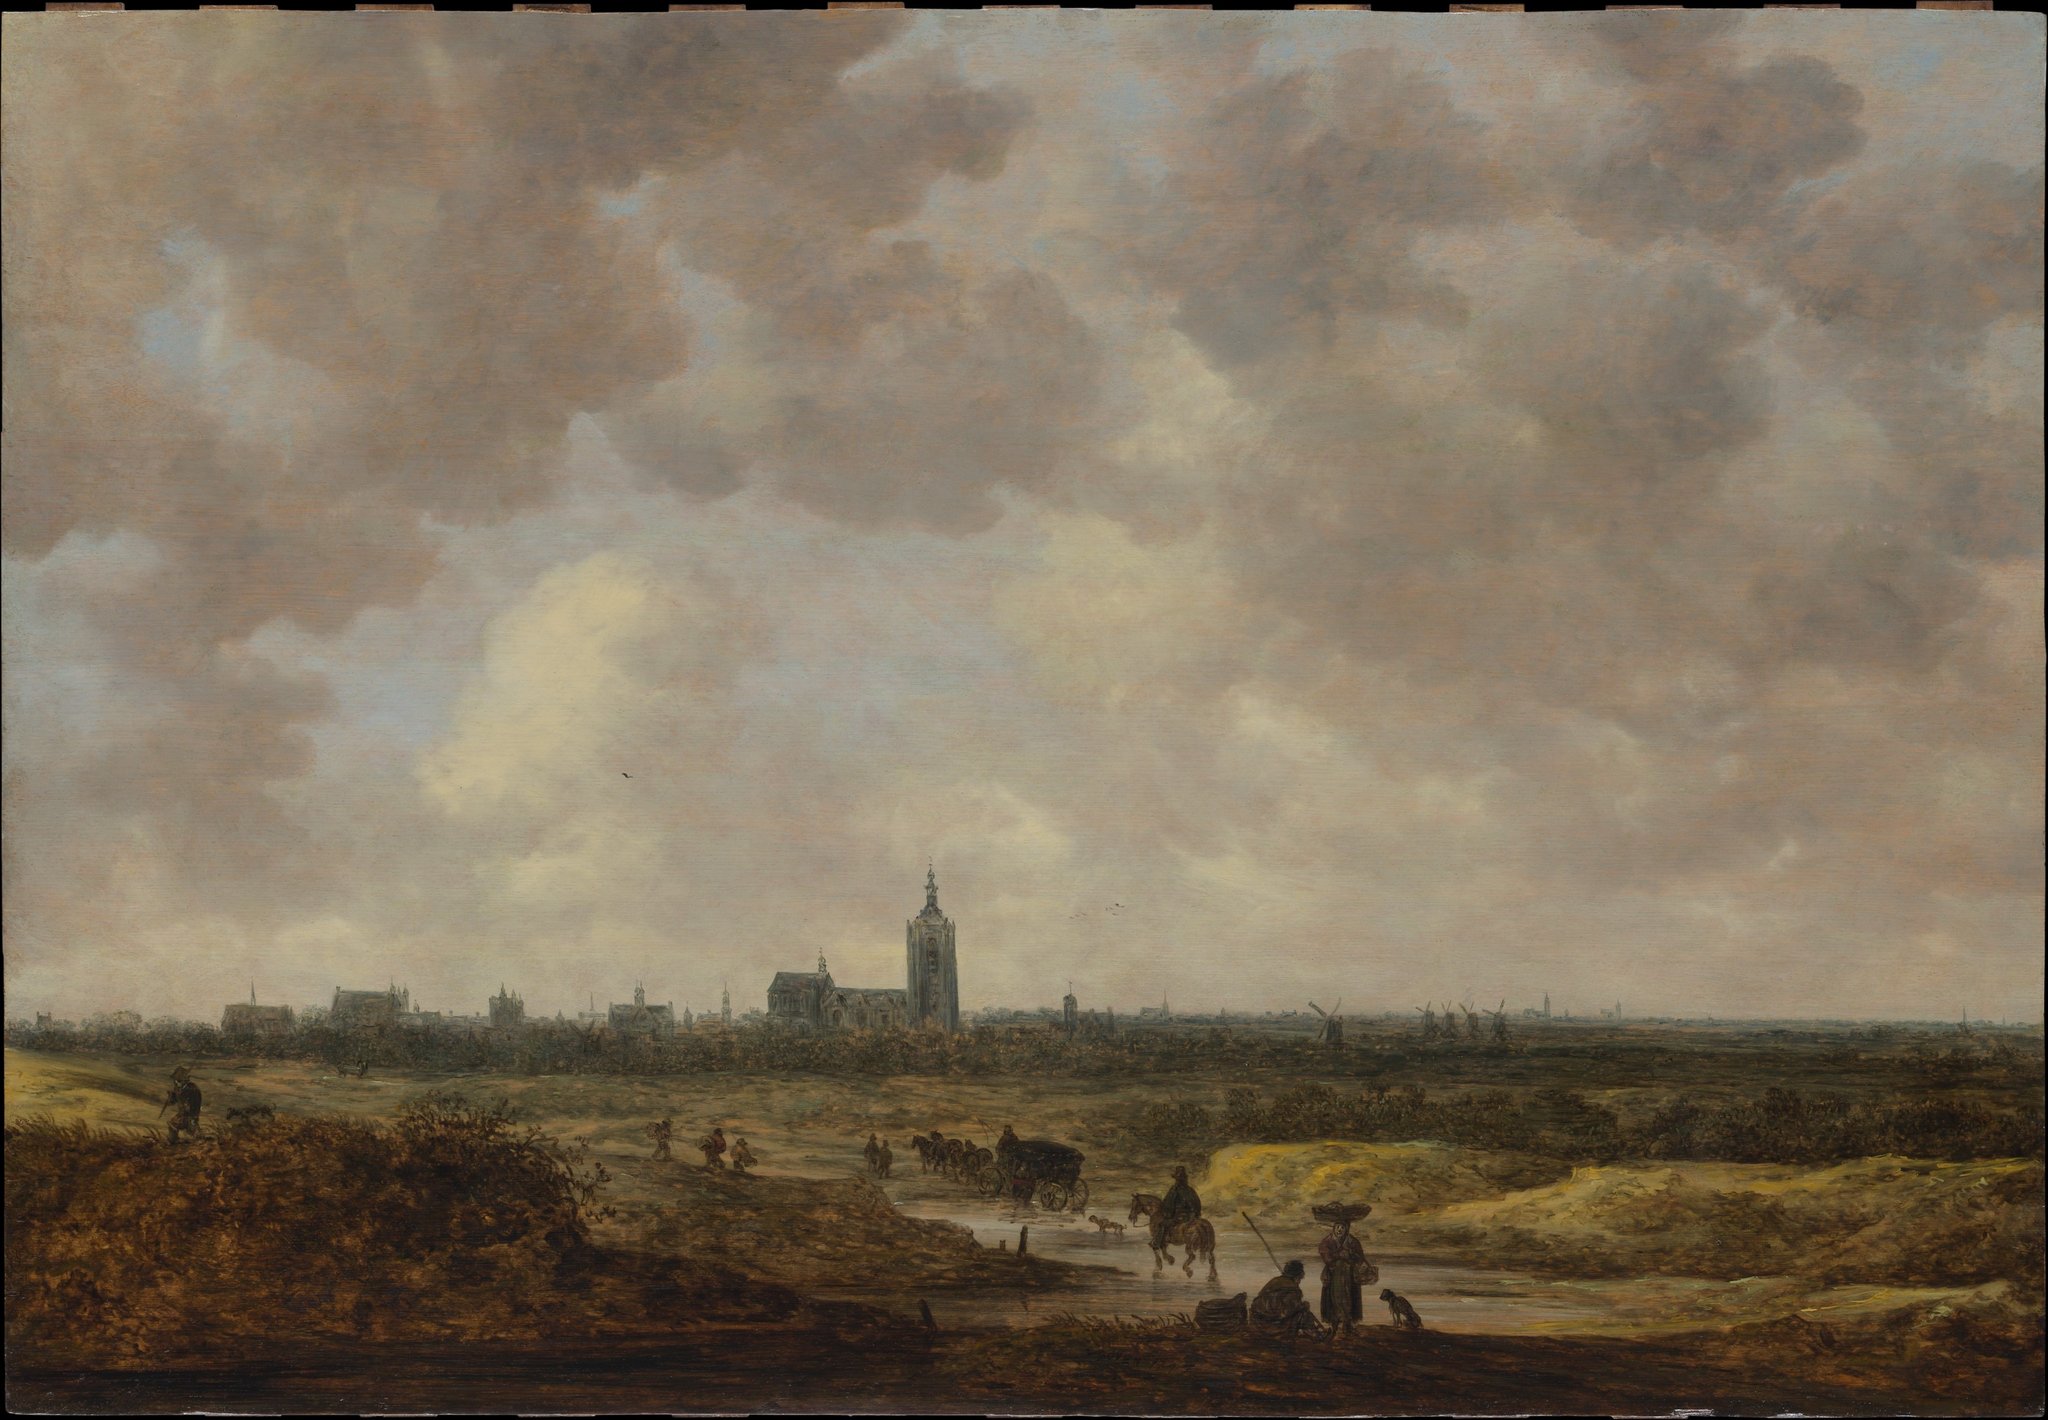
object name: painting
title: A View of The Hague from the Northwest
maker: jan van goyen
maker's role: artist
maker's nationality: dutch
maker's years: 1596-1656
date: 1647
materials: oil, wood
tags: roads,towns,landscapes